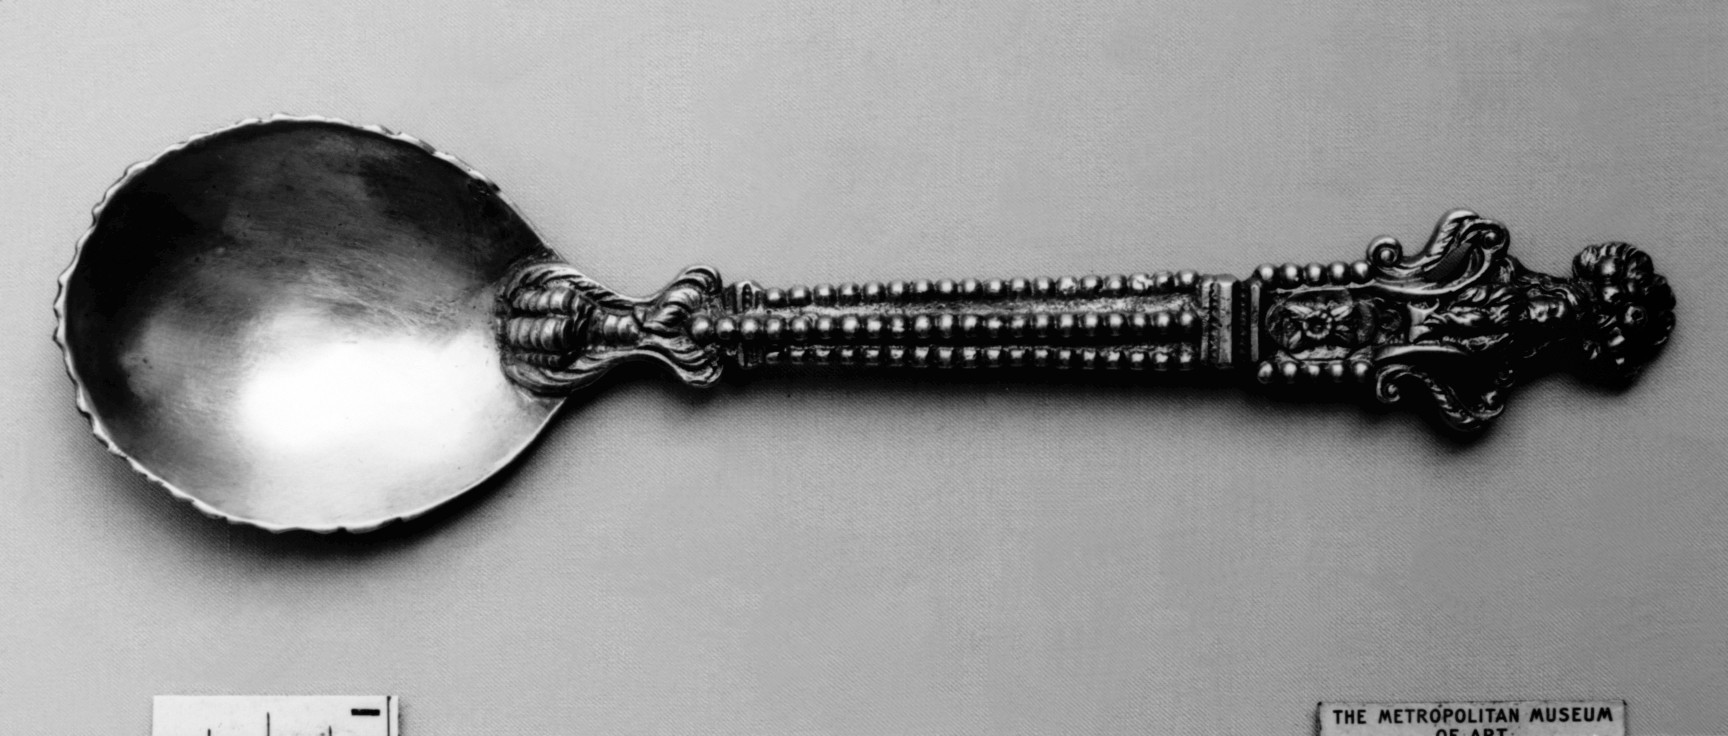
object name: spoon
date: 1701-1800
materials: silver gilt